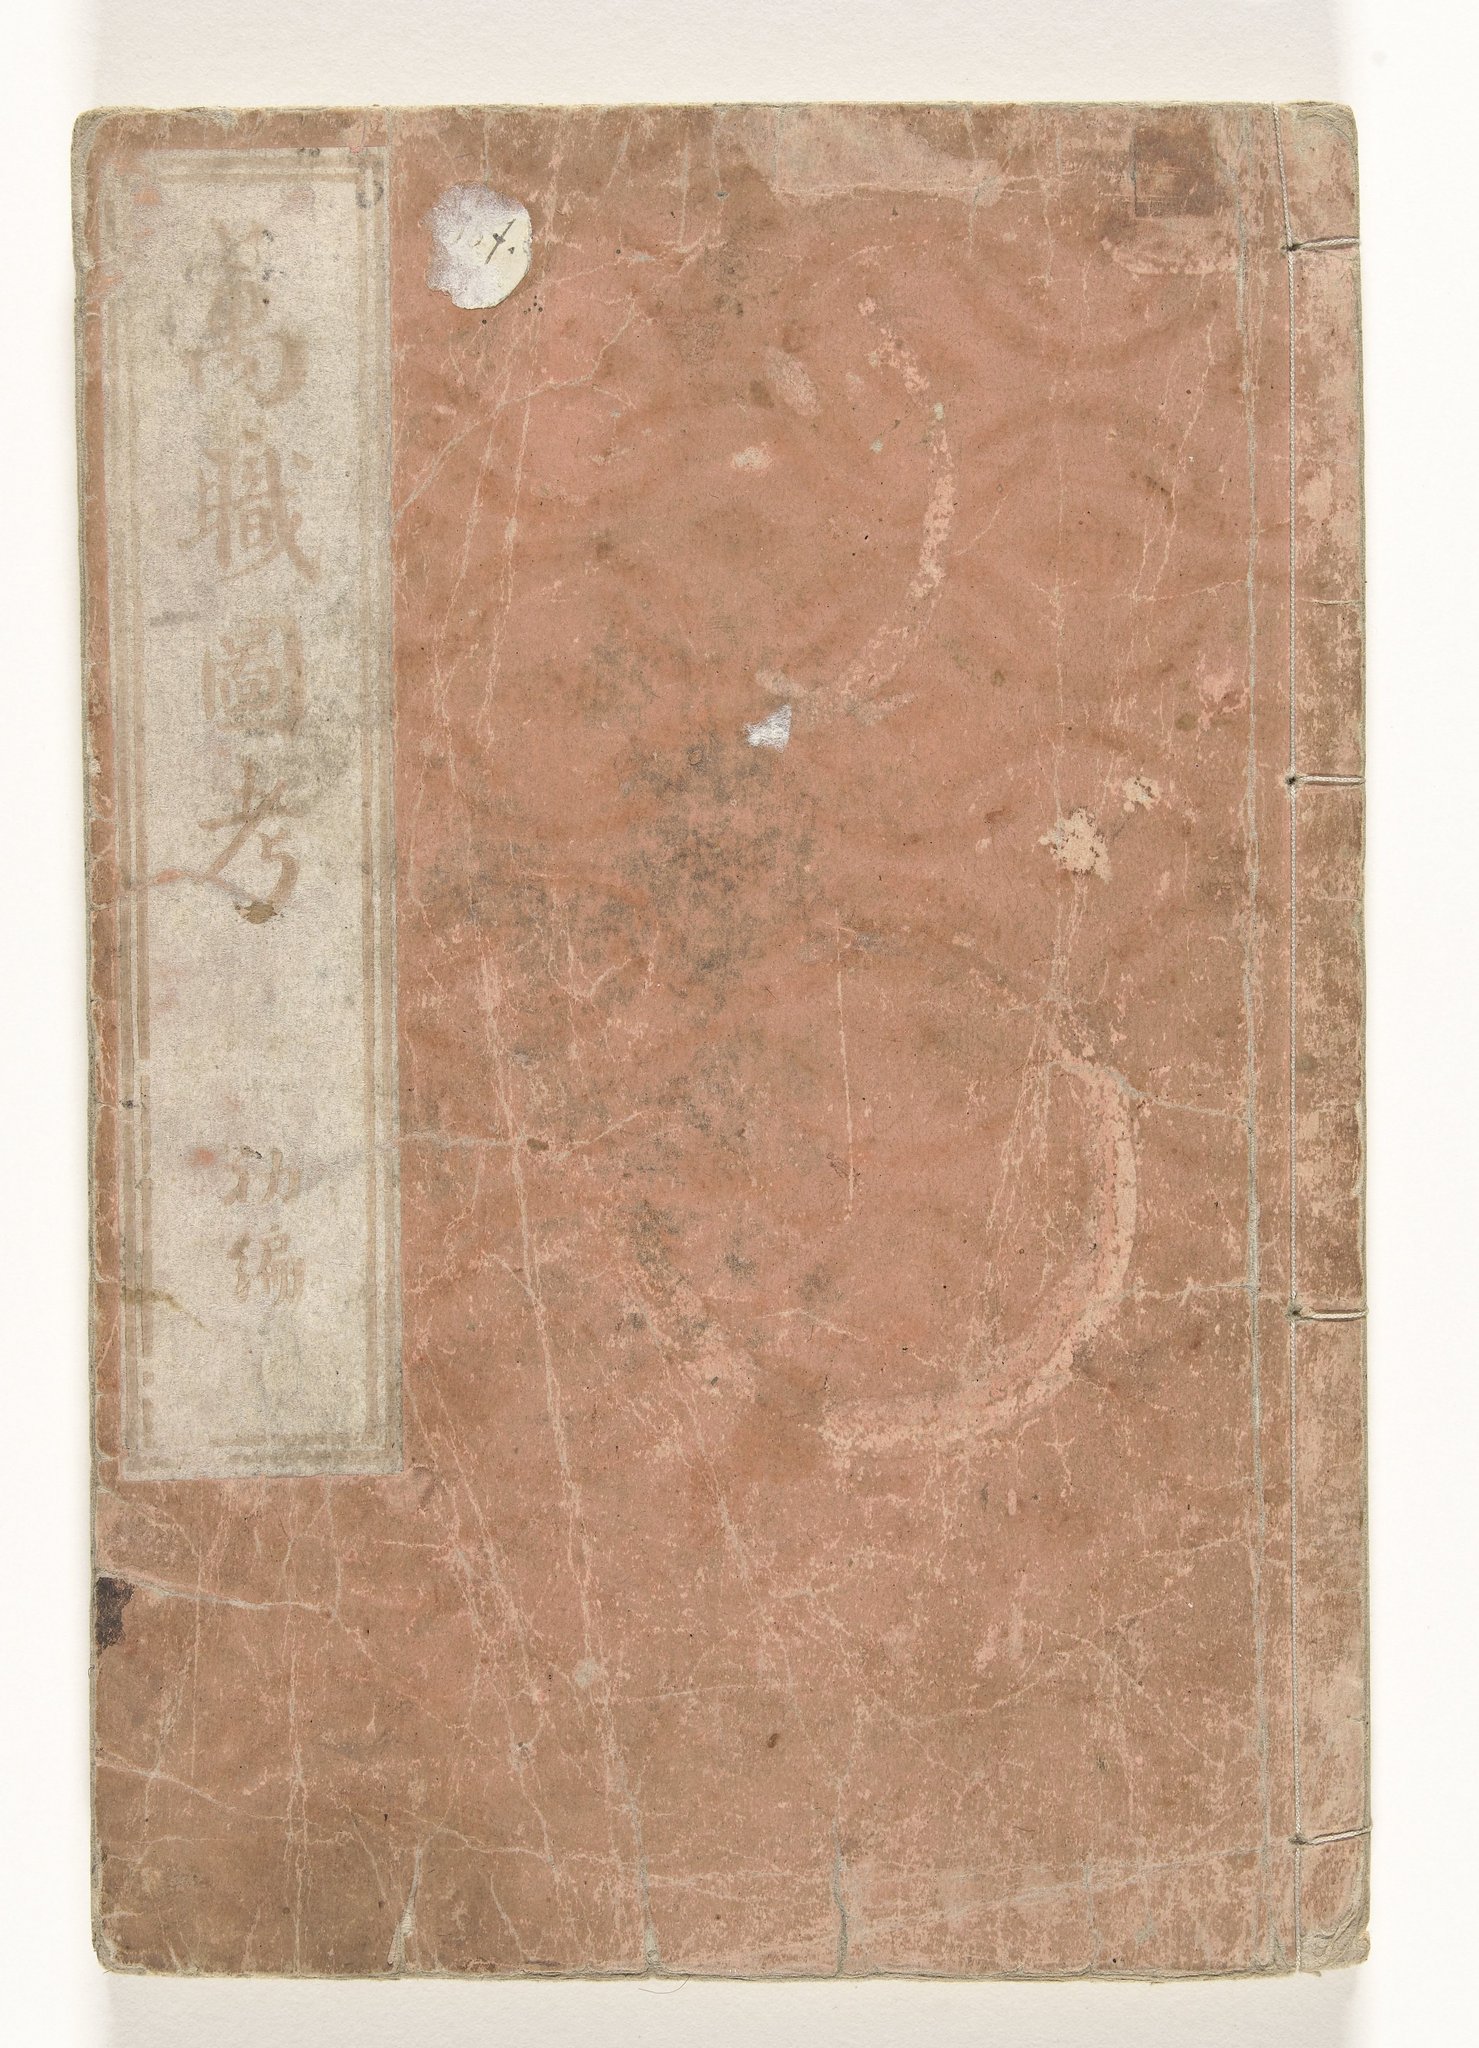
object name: book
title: Banshoku zuko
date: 1827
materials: paper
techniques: woodcut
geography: osaka